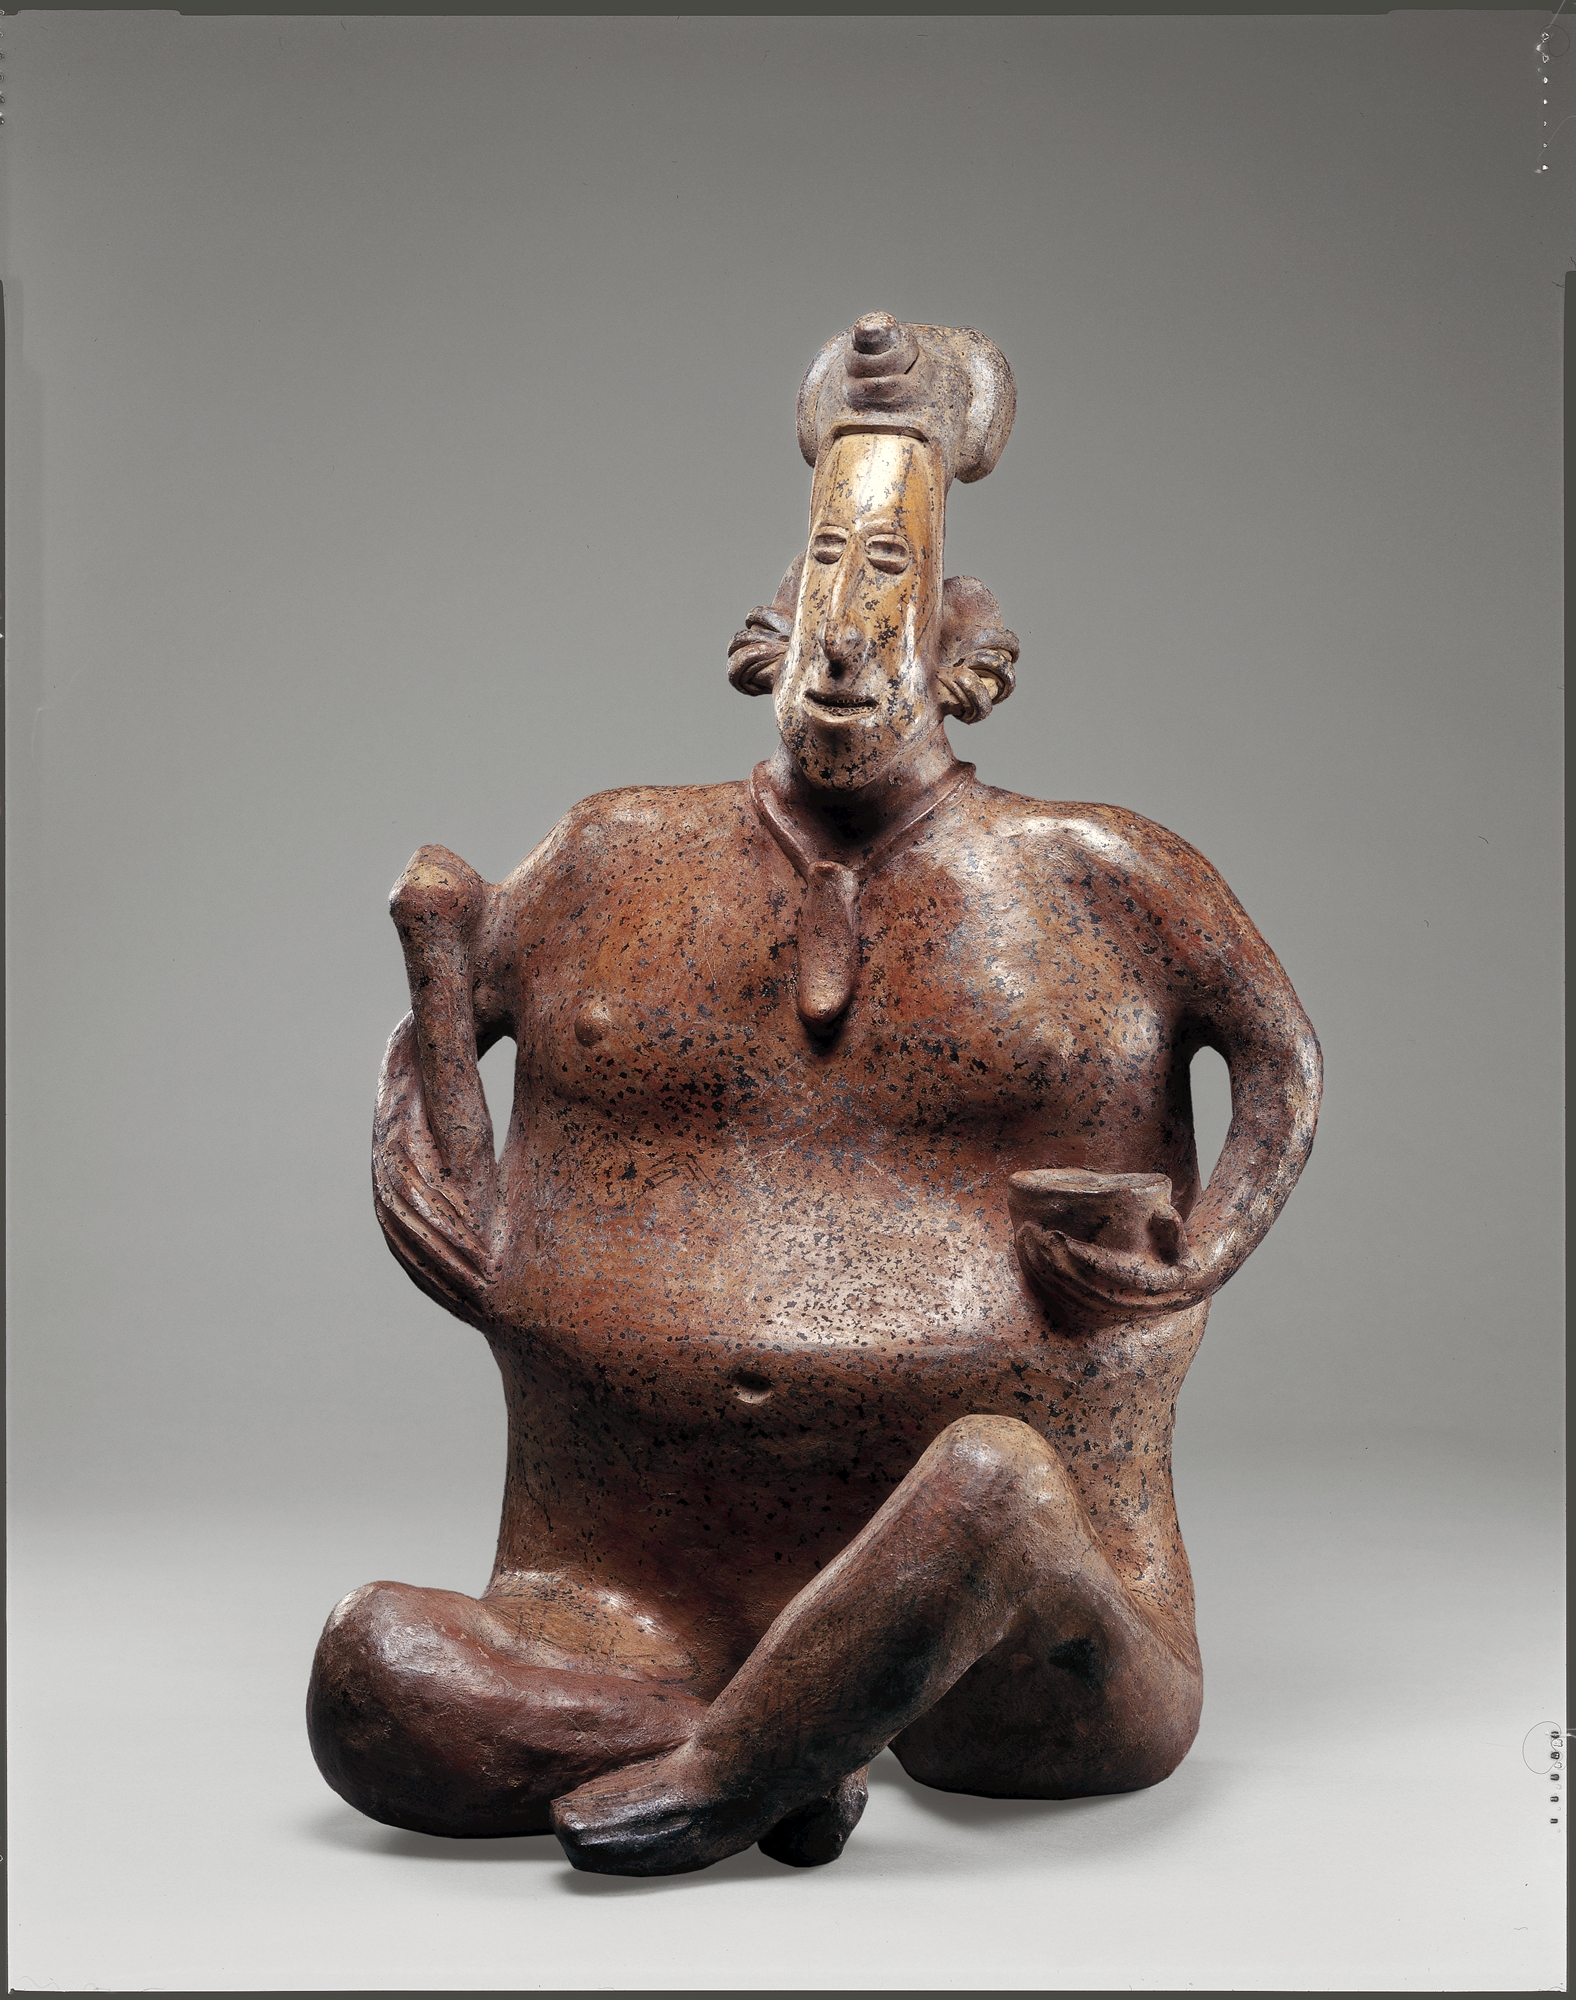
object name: figure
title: Pulque Maker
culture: jalisco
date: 100 BCE-300 CE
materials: ceramic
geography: mexico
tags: men